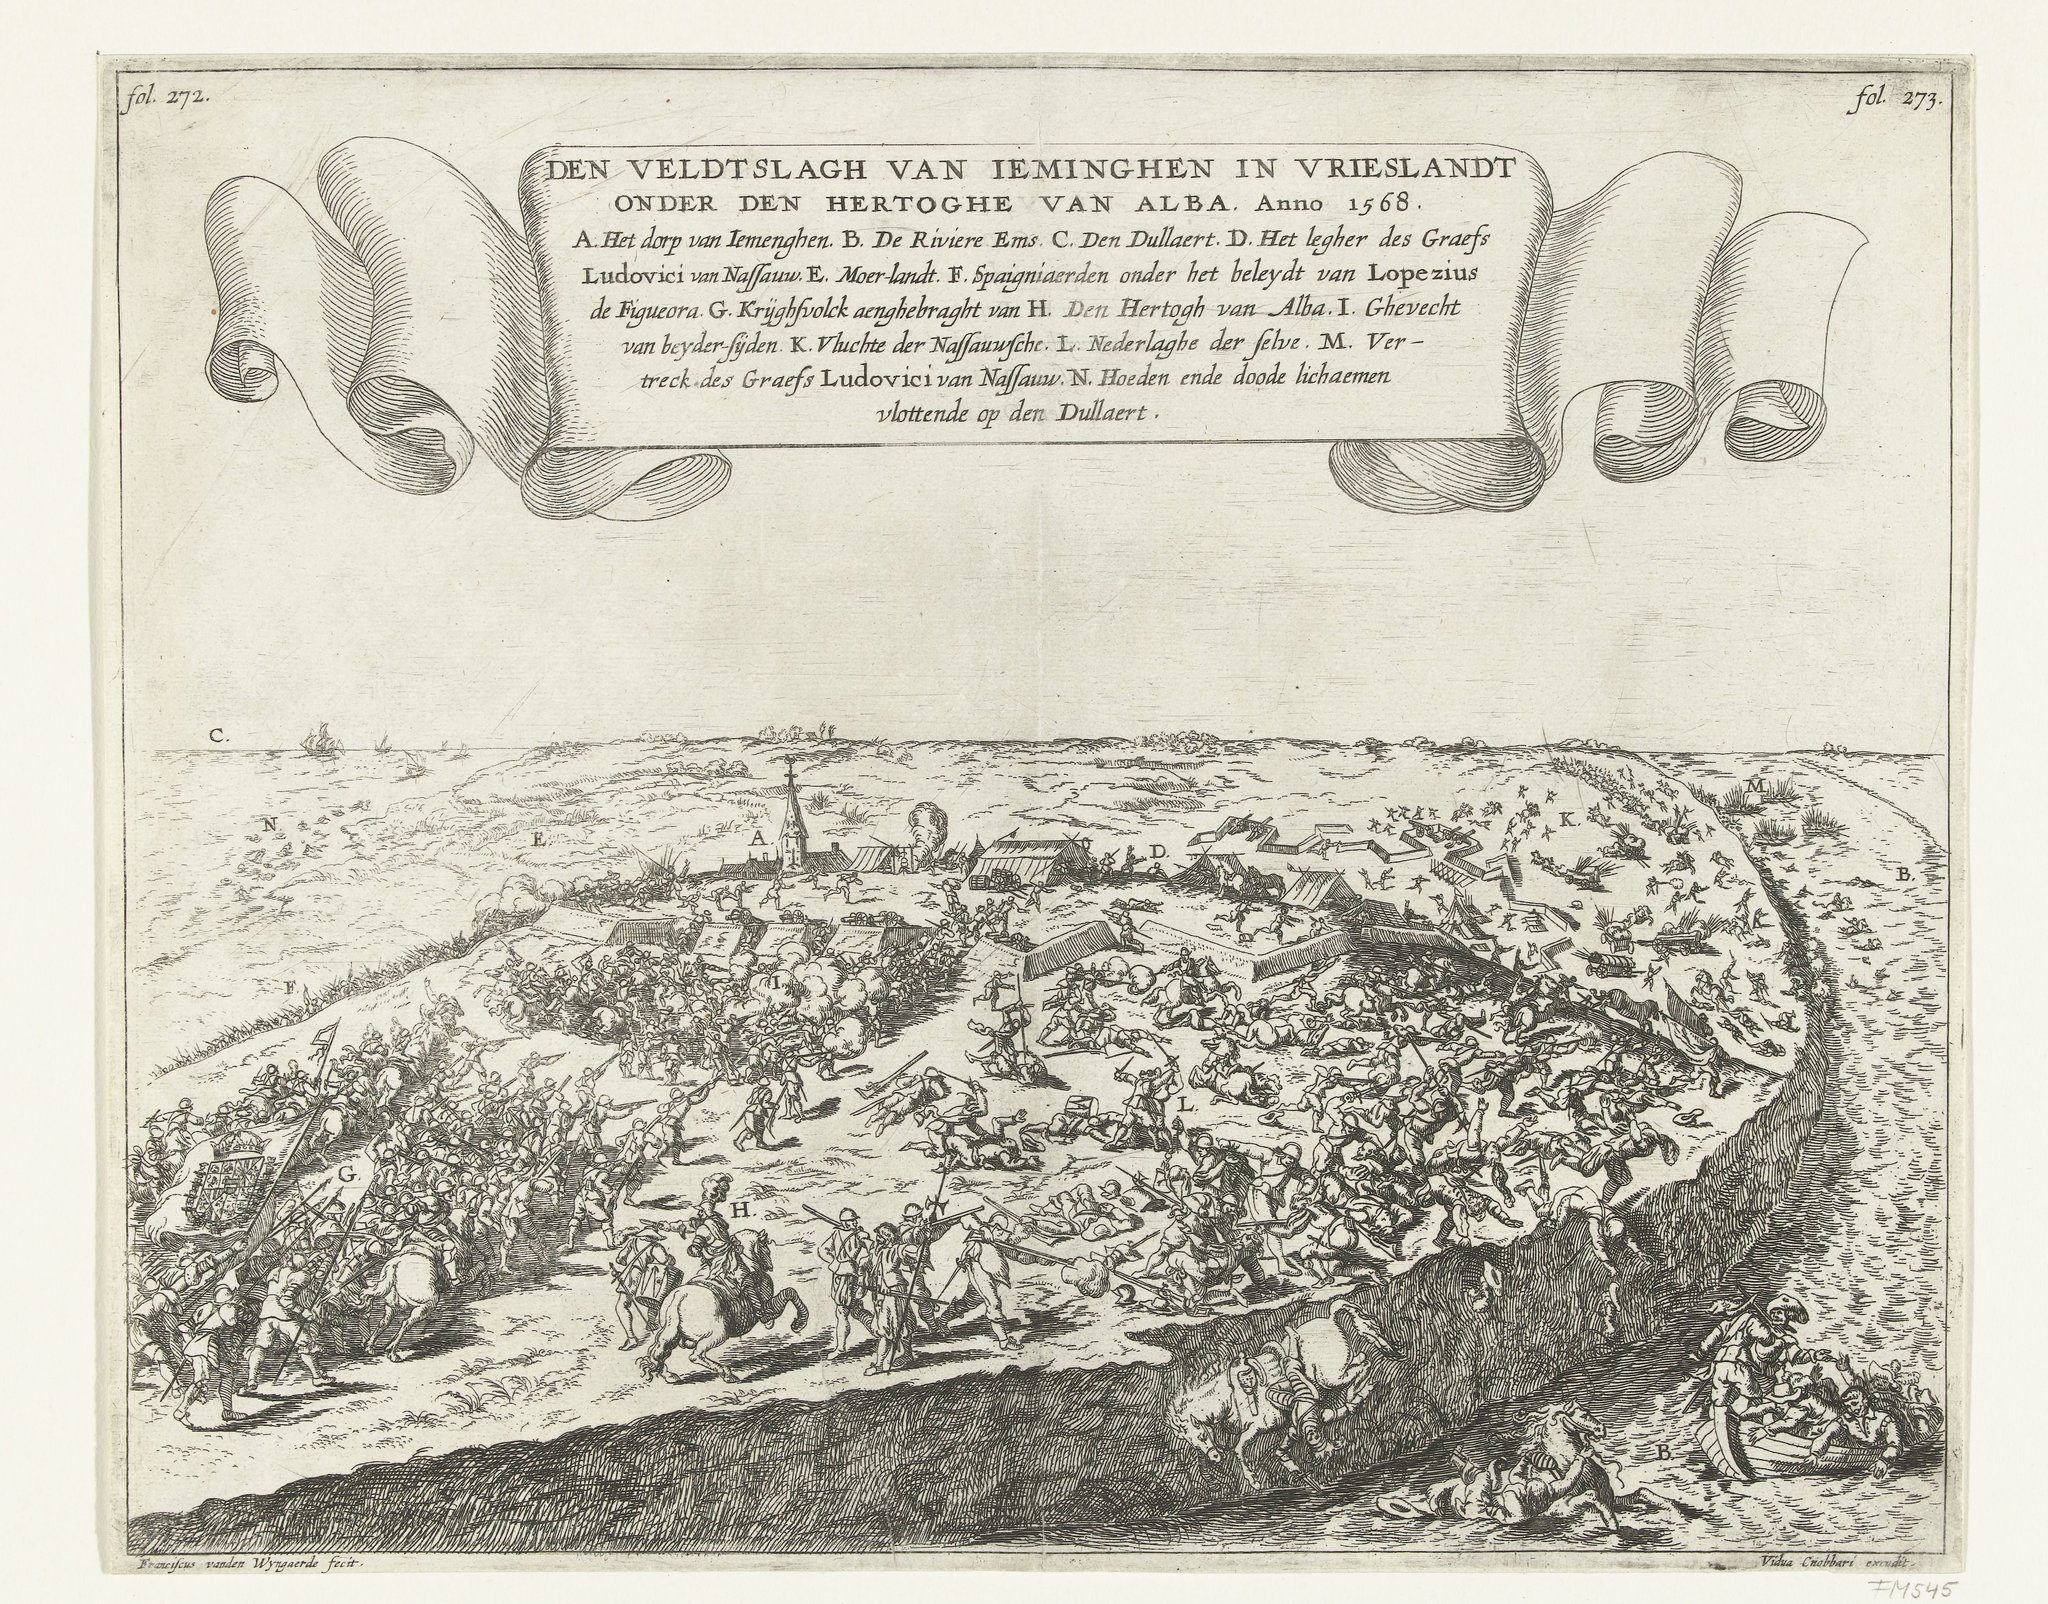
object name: print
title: Slag bij Jemmingen, 1568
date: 1643-1645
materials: paper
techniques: etching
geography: southern netherlands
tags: fernando álvarez de toledo (3rd duke of alba), battle, fighting in general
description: Slag bij Jemmingen, 21 juli 1568. Het leger van Lodewijk van Nassau wordt door Alva verslagen bij het dorpje Jemmingen. Rechts de rivier de Eems met roeibootjes met overlevenden. Bovenin een banderol met de titel en legenda A-N in het Nederlands.